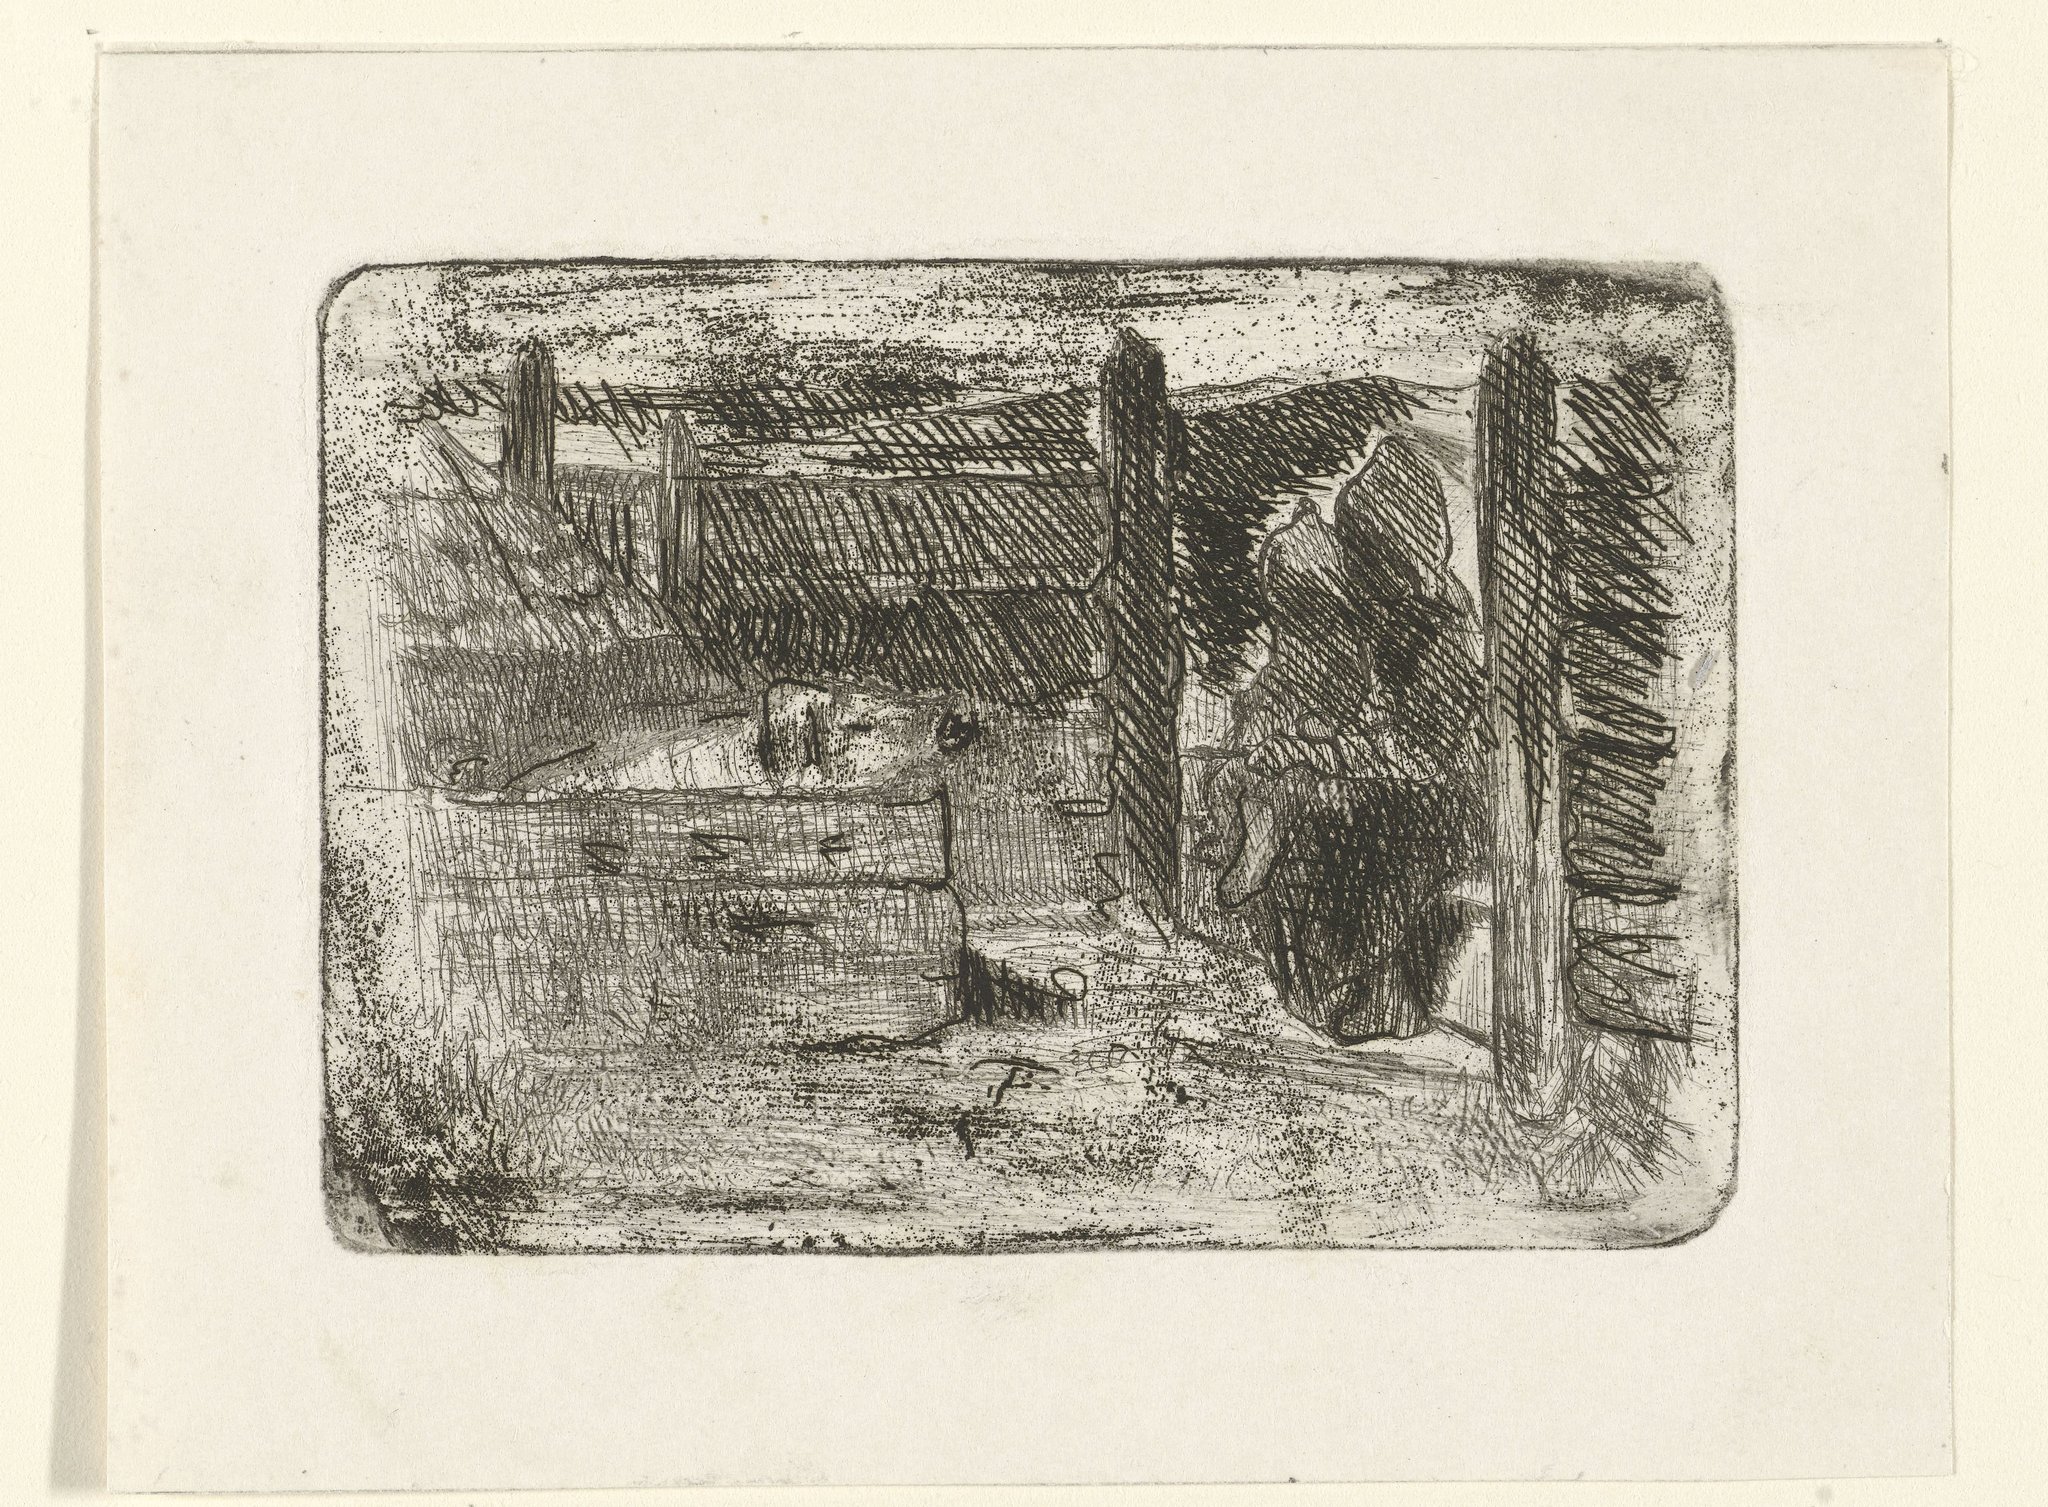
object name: print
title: Kinderen bij het varkenskot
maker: jozef israëls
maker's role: draughtsman, painter, print maker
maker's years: 1824-1911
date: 1835-1888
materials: paper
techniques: etching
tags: pig, boy (child between toddler and youth), girl (child between toddler and youth)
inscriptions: collector's mark: Lugt 2228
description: Twee kinderen, een meisje en een jongen, zitten op een hek bij een varkenskot.